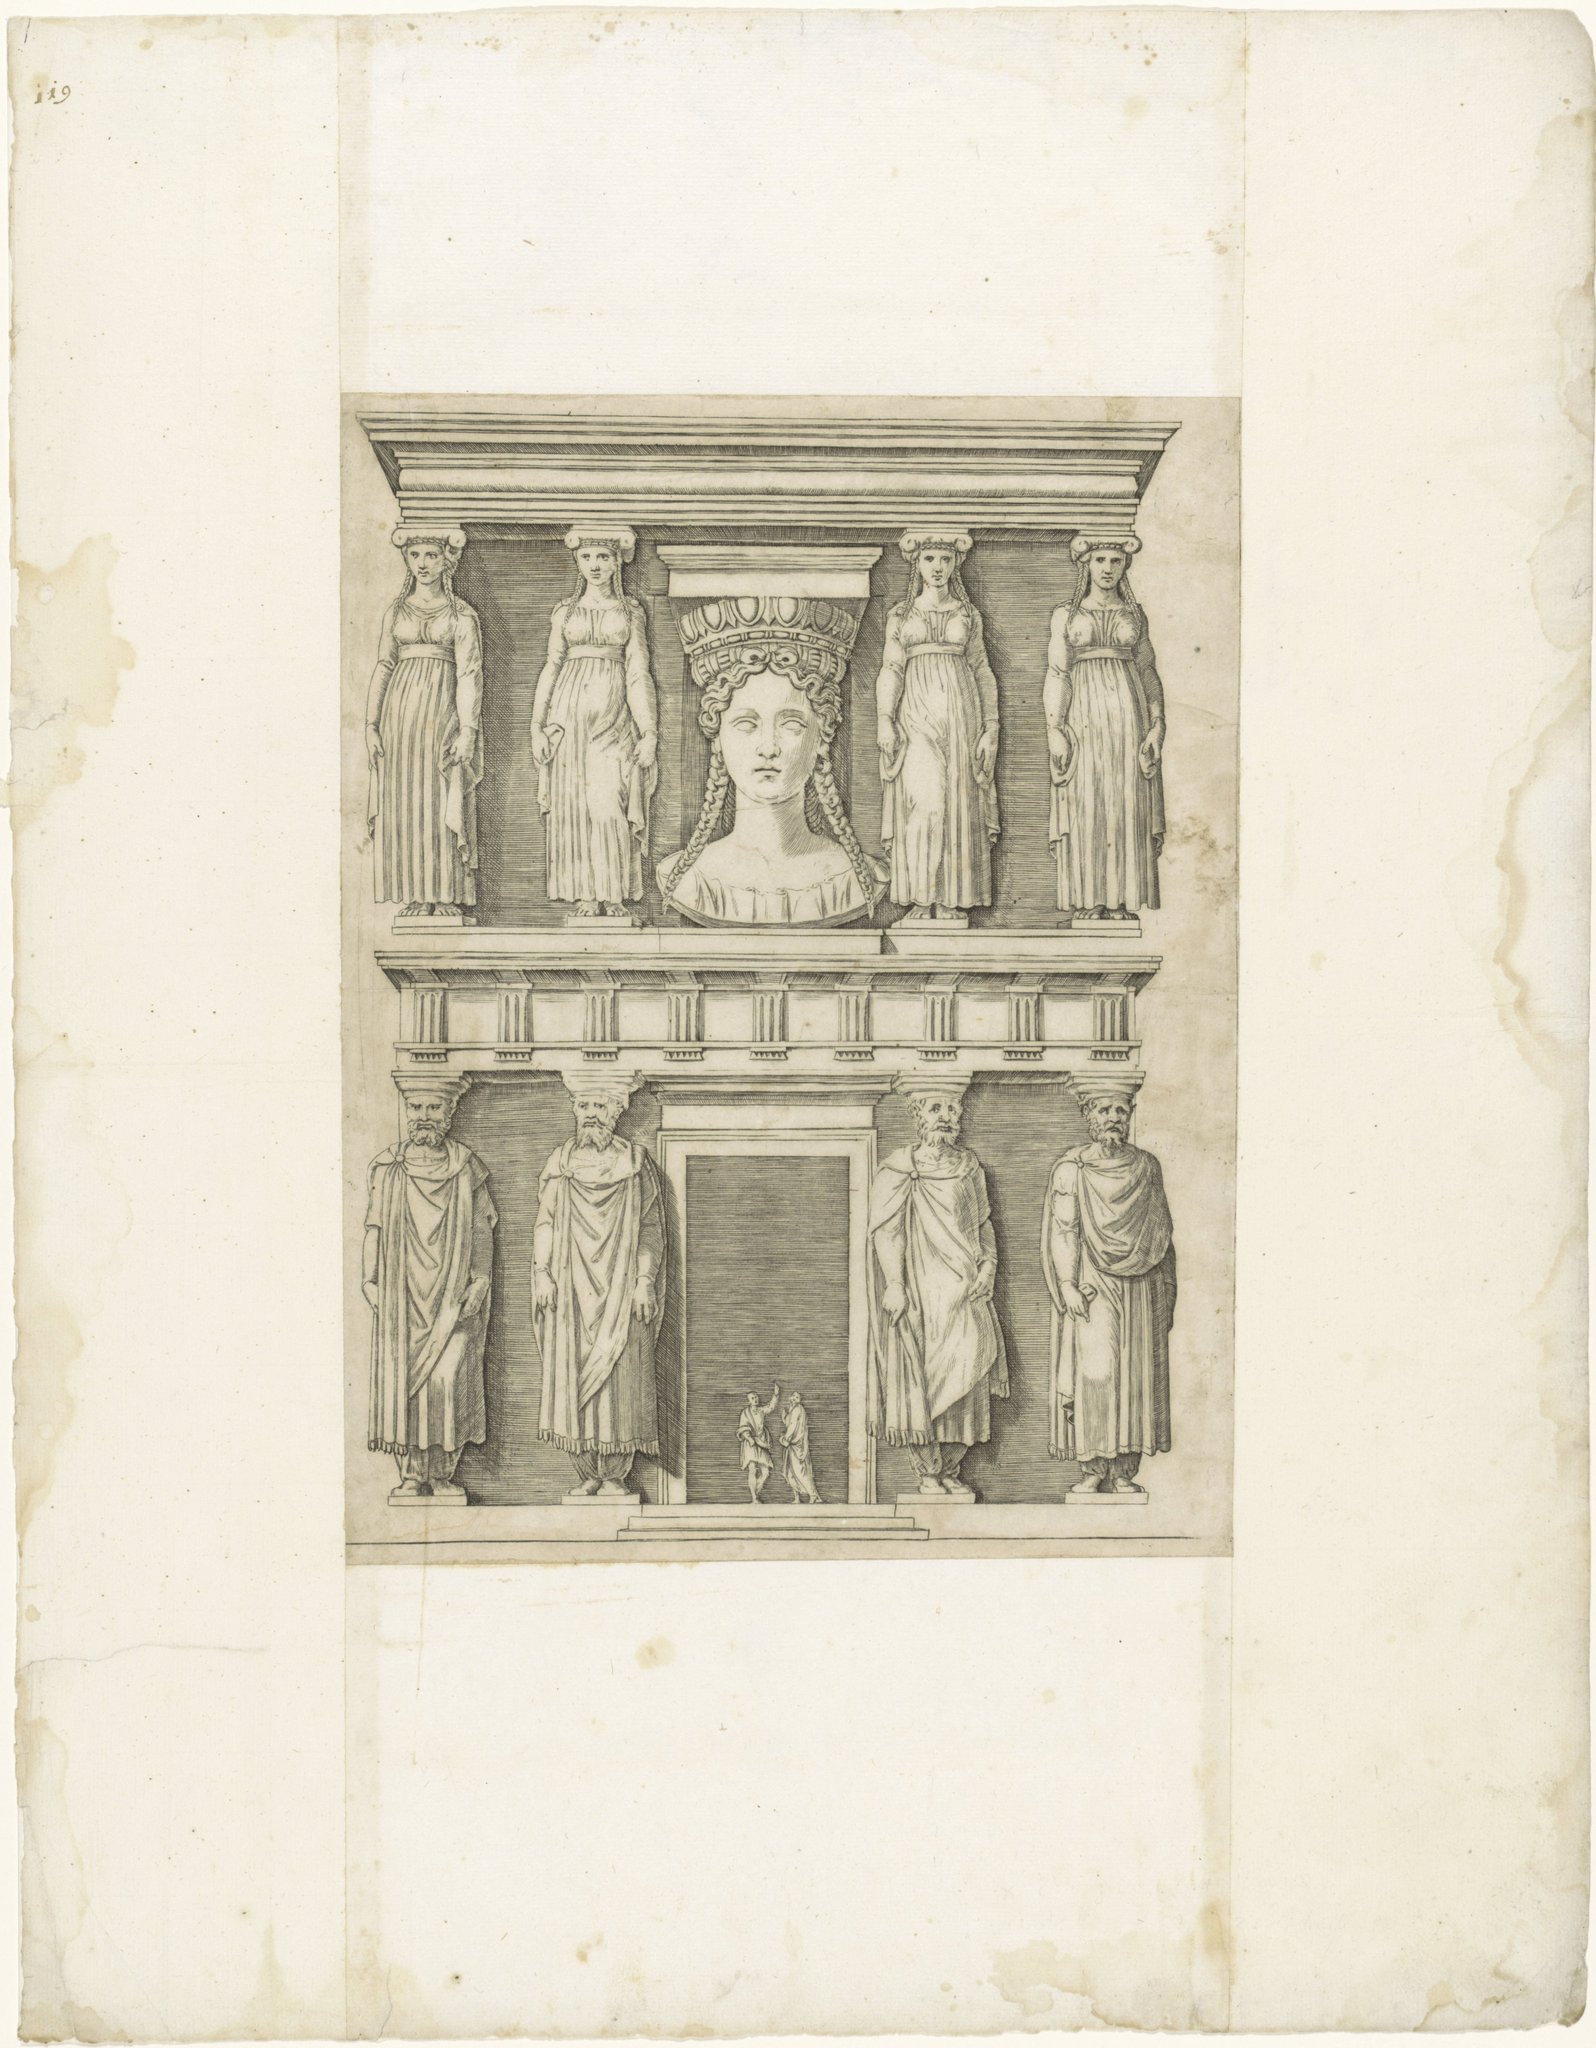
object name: album leaf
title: Façade met kariatiden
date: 1502-1534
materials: paper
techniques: engraving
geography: italy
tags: caryatids ~ architecture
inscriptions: number: ‘119’, watermark, collector's mark: Lugt 2228, collector's mark: Lugt 2760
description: Folio 119 uit het prentalbum van Johann Georg I. Zobel von Giebelstadt (Röttingen 1543-07-20 - Bamberg 1580-09-07), de latere bisschop van Bamberg. Het album is vermoedelijk samengesteld tussen 1568 en 1570 in Venetië. Het album werd in 1999 uit elkaar genomen door een antiquair. De in totaal 124 folio's met prenten uit het "Zobel Album" werden aangekocht door verschillende musea en privéverzamelingen. De grootste groep (68 folio's) bevindt zich in de collectie van het Rijksmuseum.